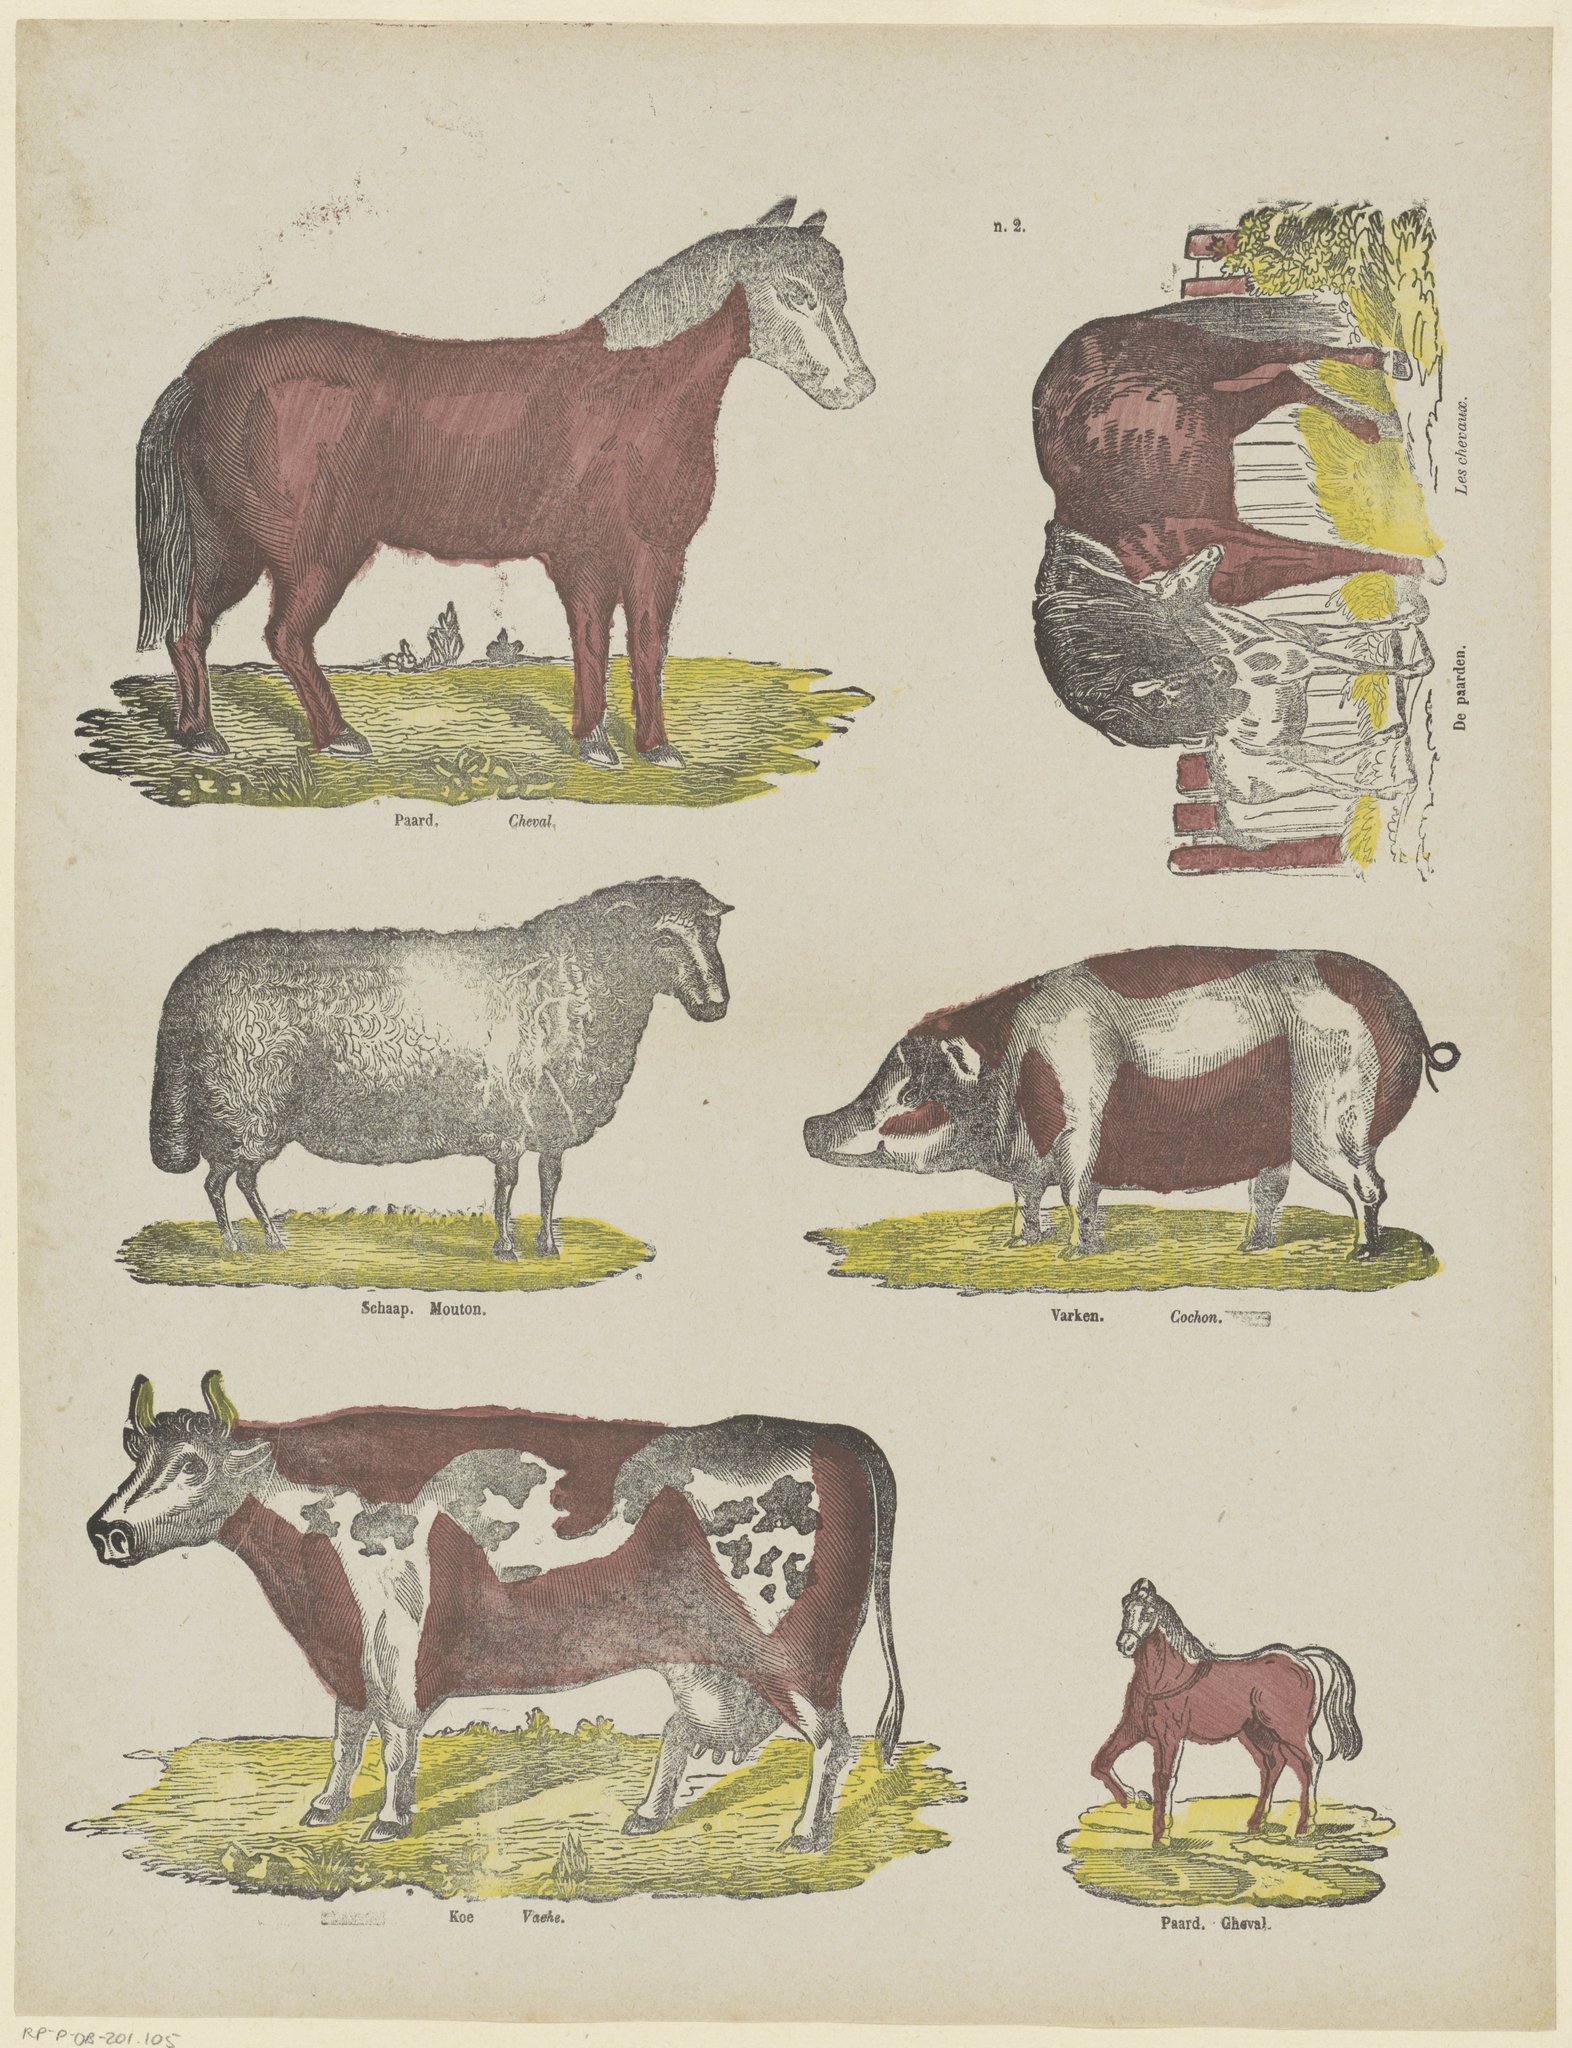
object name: popular print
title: Dieren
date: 1866-1902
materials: paper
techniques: colour, letterpress printing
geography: turnhout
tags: pig, cow, animals, sheep, horse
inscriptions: collector's mark: Lugt 2760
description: Blad met 6 voorstellingen van boerderijdieren, zoals paarden, een schaap, een varken en een koe. Onder elke voorstelling een onderschrift in het Nederlands en in het Frans. Genummerd midden boven: n. 2.